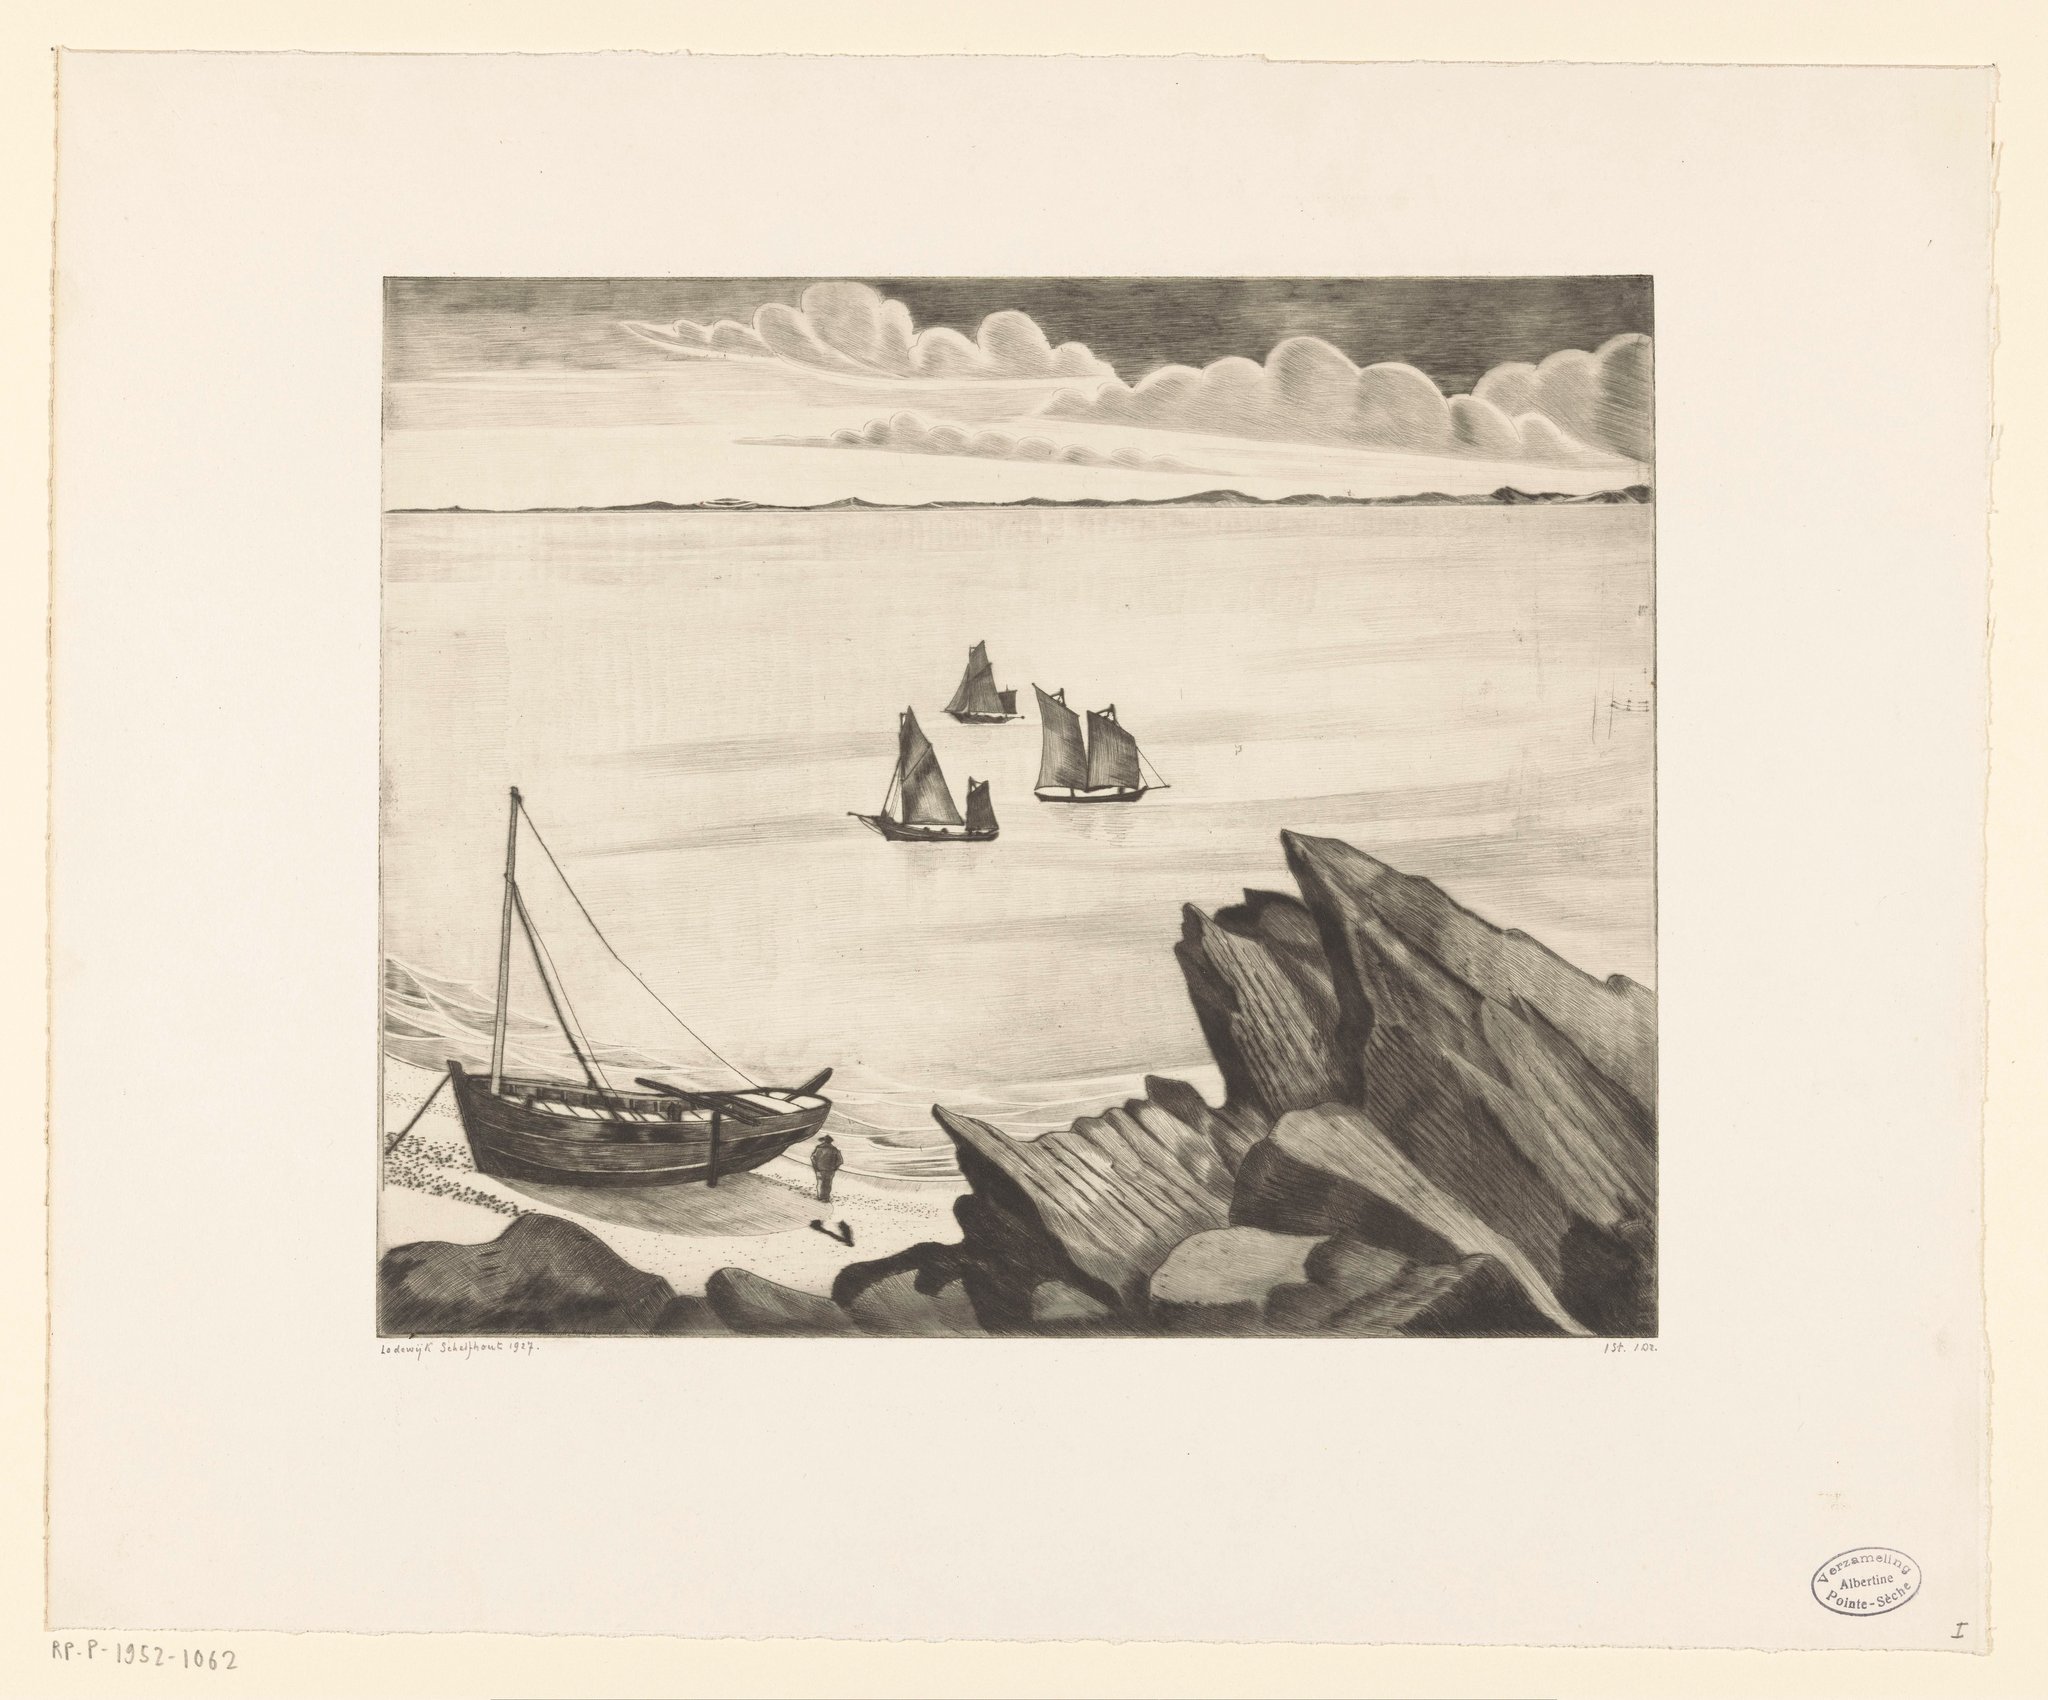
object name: print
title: Sur la côte de Quiberon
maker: lodewijk schelfhout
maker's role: draughtsman, print maker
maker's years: 1881-1943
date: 1927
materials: paper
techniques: drypoint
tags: sailing-ship, sailing-boat, rocky coast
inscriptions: collector's mark: Lugt 5i, collector's mark: Lugt 2228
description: Drie zeilschepen op zee en één op het strand bij de plaats Quiberon in het Franse Bretagne. Op de voorgrond rotsen.